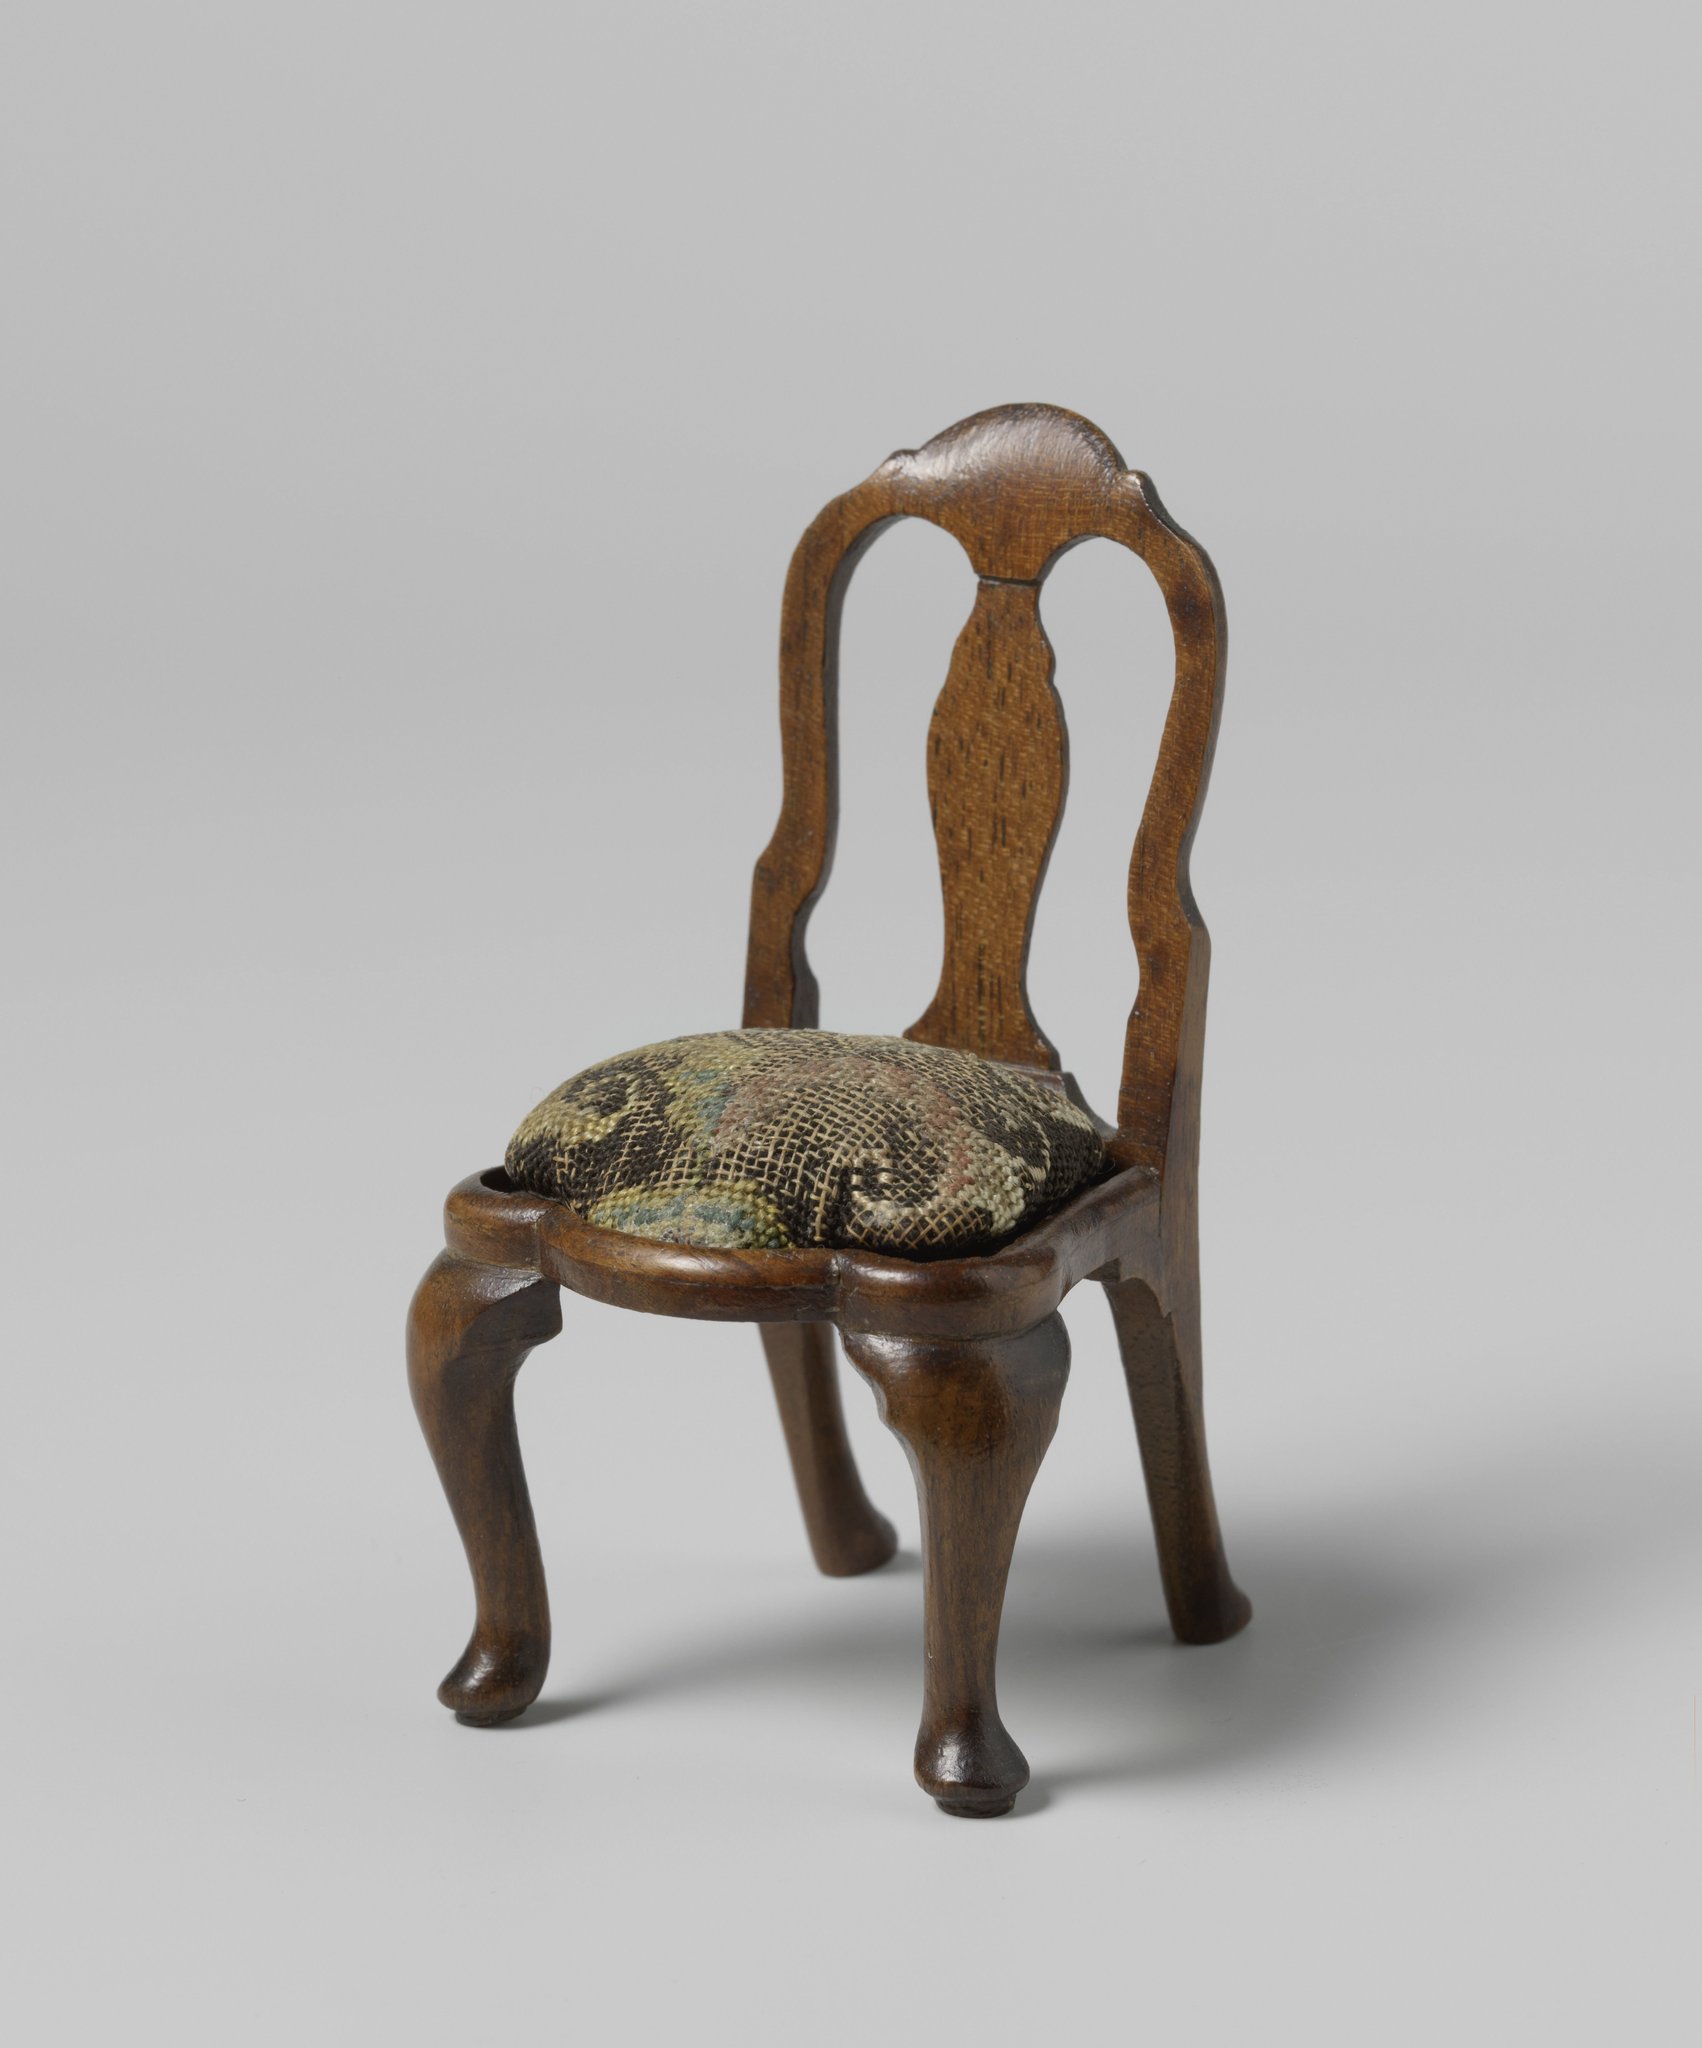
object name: chair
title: Stoel, behorend tot een elfdelig ameublement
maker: Anonymous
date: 1750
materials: silk, wood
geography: amsterdam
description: Stoel, vervaardigd van notenhout, behorend tot een elfdelig ameublement, bestaande uit een bank en tien stoelen. De zitting van buurduurwerk met blad- en bloemmotieven in zijde op linnen stramien, met een zachte vulling.